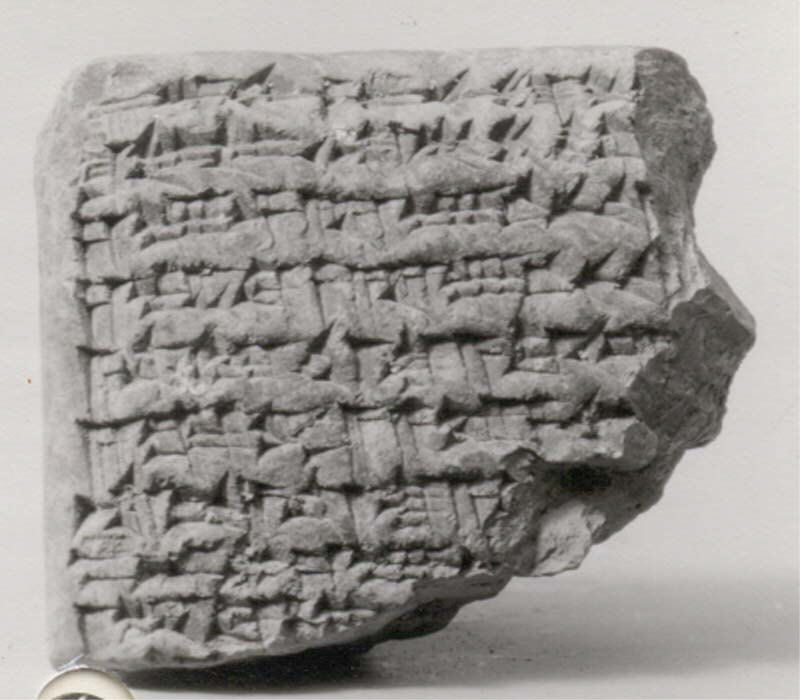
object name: cuneiform tablet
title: Cuneiform tablet: cession of promissory note (?), Esagilaya archive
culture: babylonian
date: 555-539 BCE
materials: clay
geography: mesopotamia